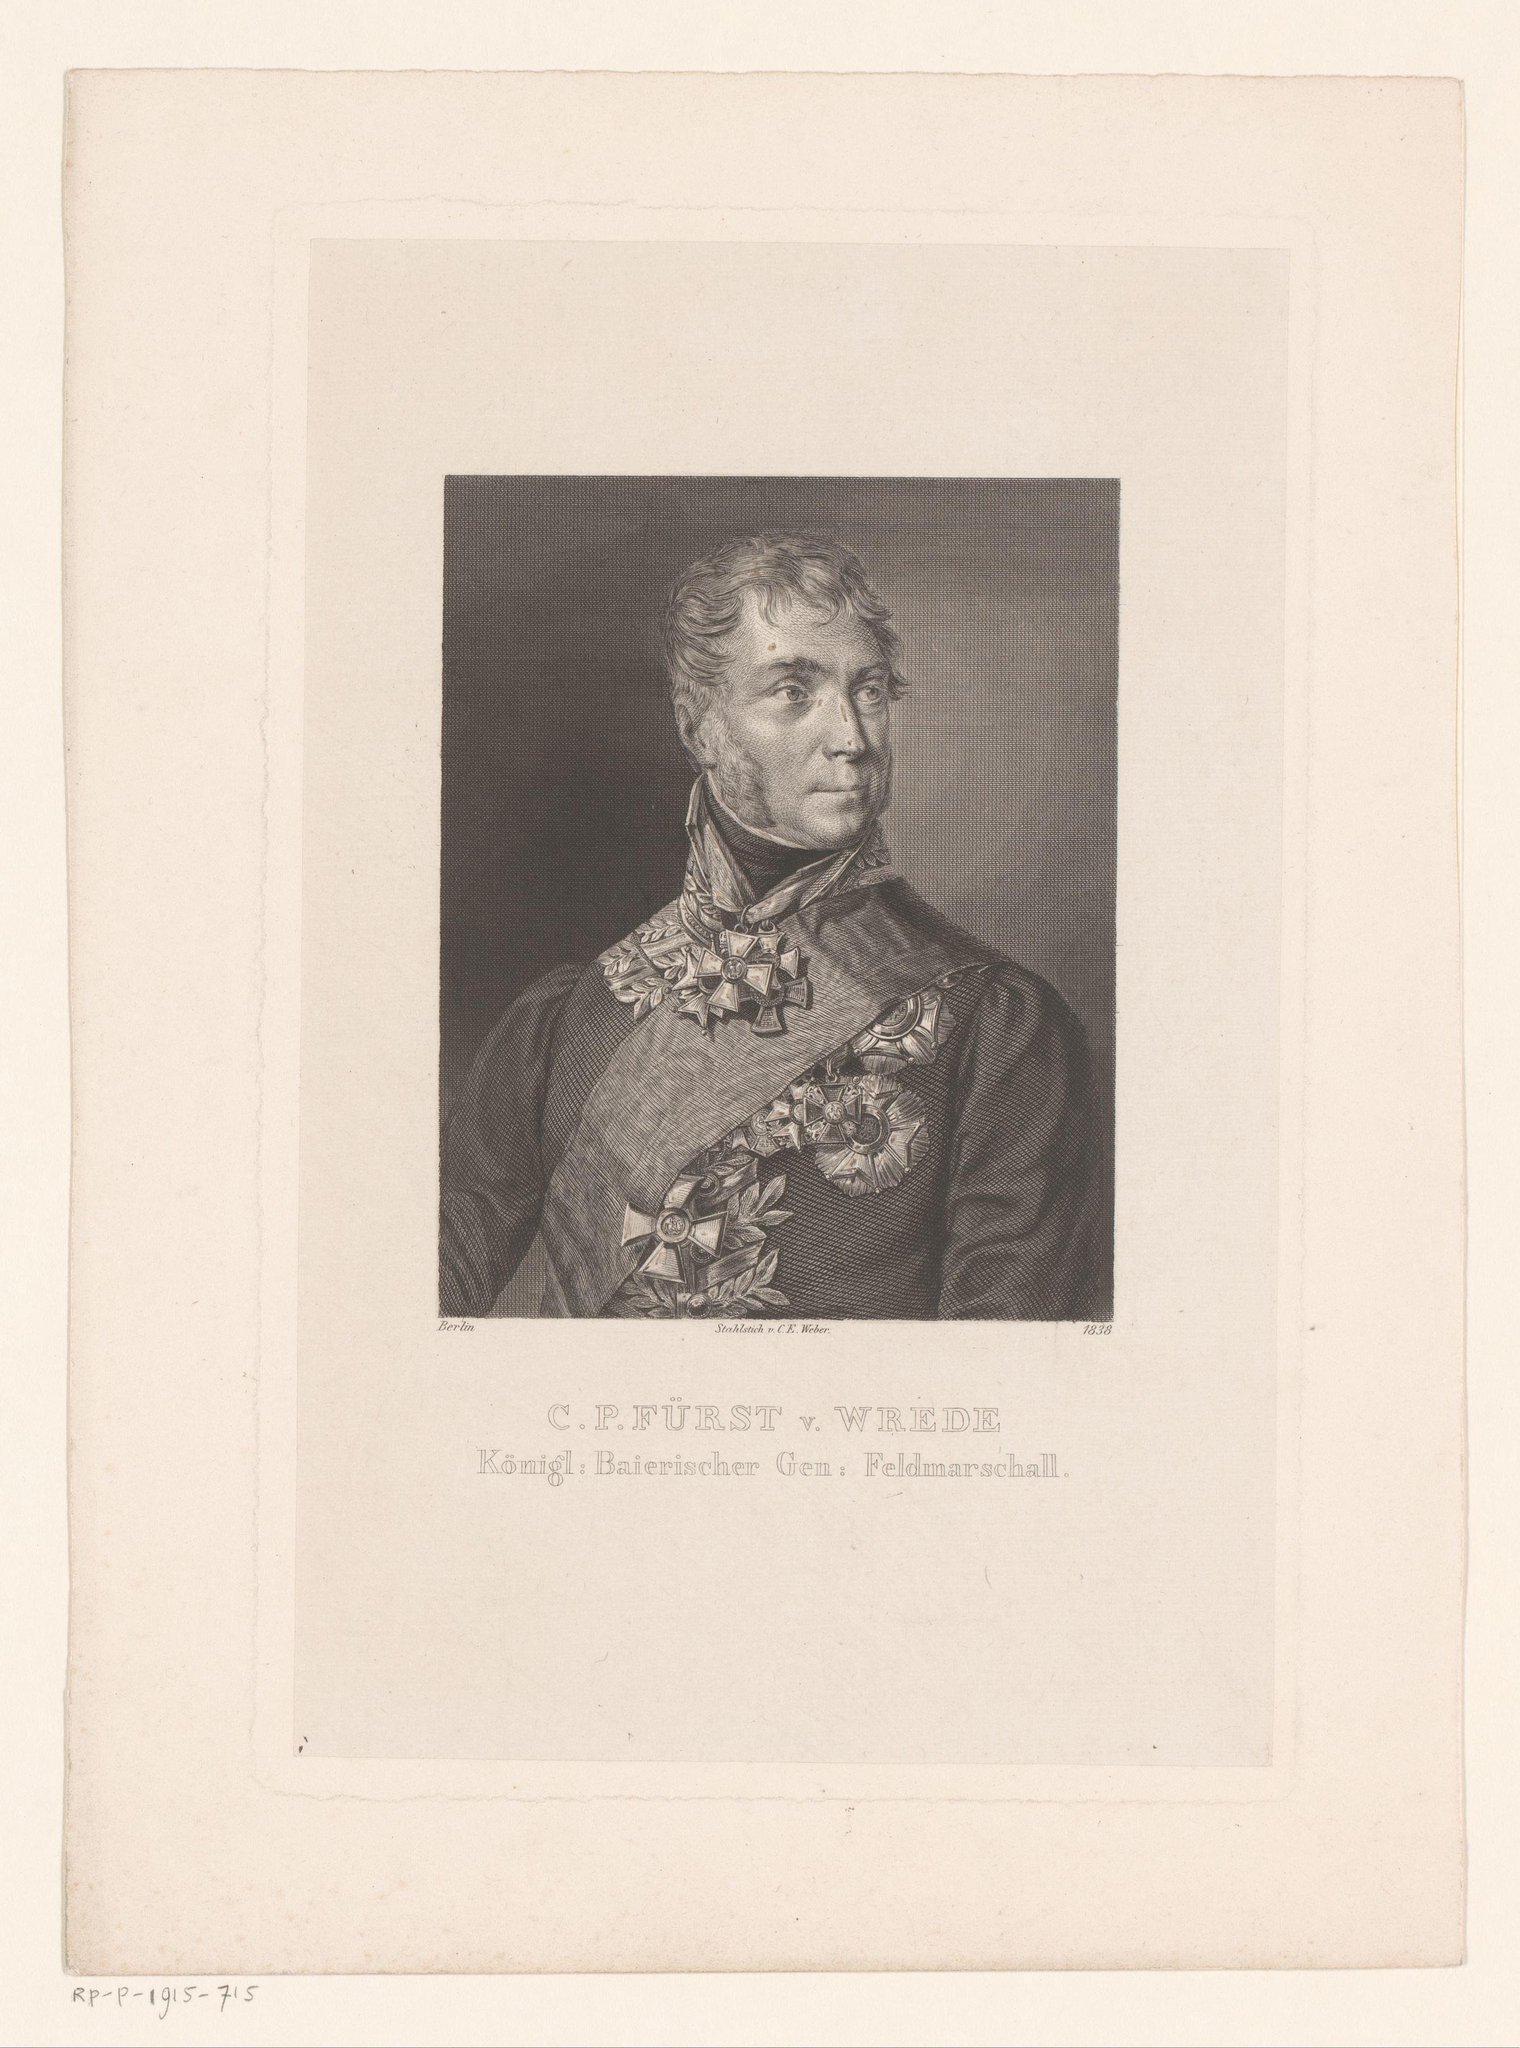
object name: print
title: Portret van Carl Philipp von Wrede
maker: karl eduard weber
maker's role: draughtsman, painter, print maker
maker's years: 1806-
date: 1838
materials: paper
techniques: engraving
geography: berlin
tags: historical persons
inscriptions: collector's mark: Lugt 2228